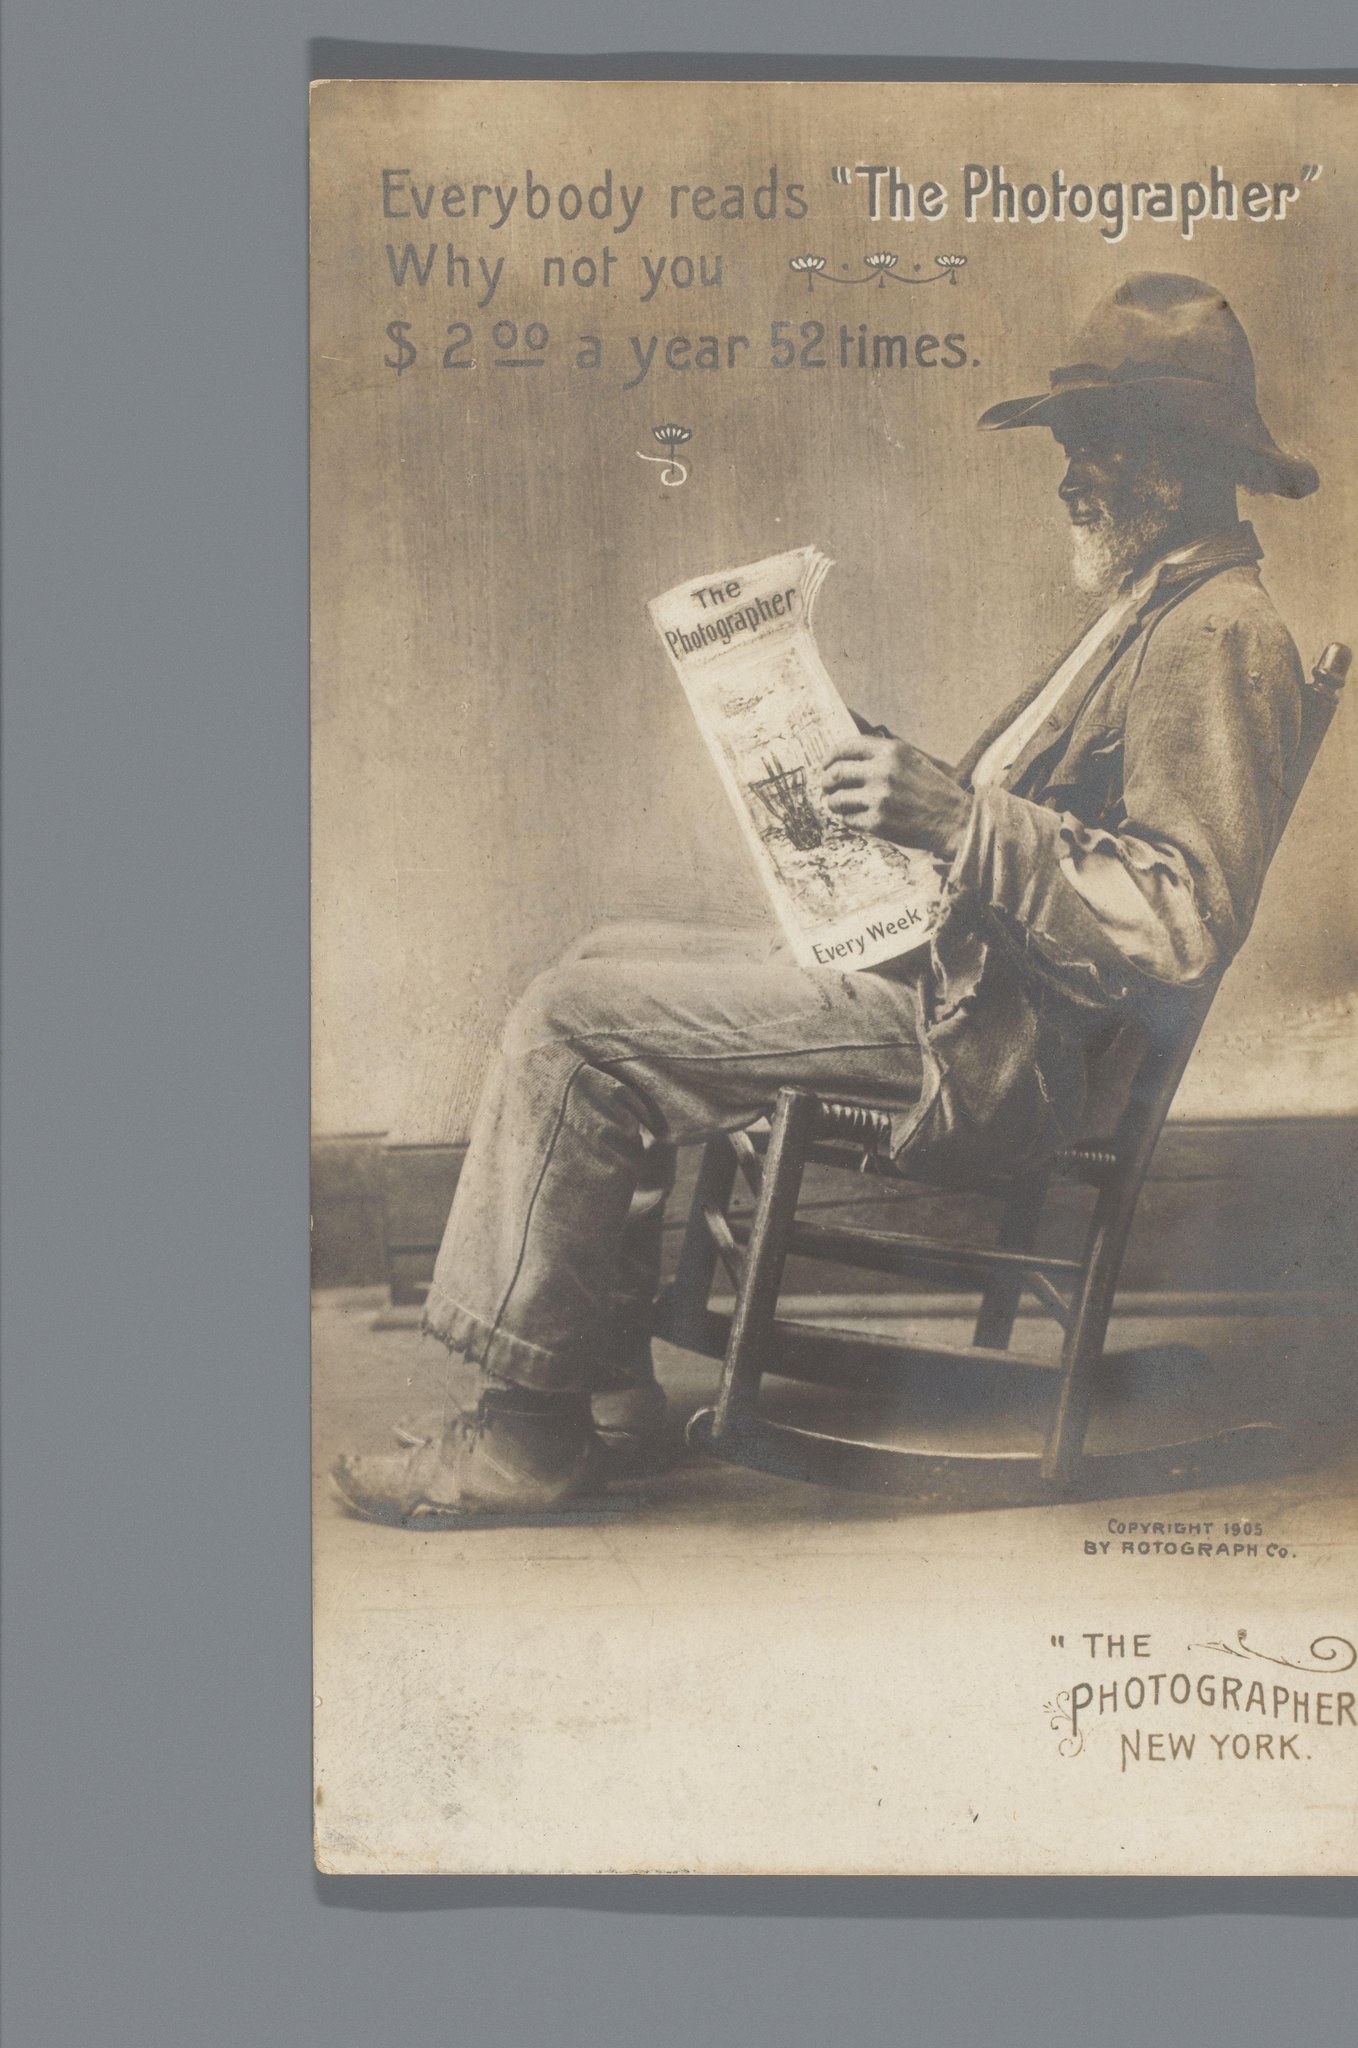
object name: ansichtkaart, prentbriefkaart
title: Reclame voor een krant genaamd ‘The Photographer’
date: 1905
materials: photographic support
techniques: gelatin silver print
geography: united states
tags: united states of america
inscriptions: inscription: ‘Everybody reads “The Photographer” / Why not you / $ 2oo a year 52 times. / Copyright 1905 / BY ROTOGRAPH Co. / “THE / PHOTOGRAPHER” / NEW YORK.’